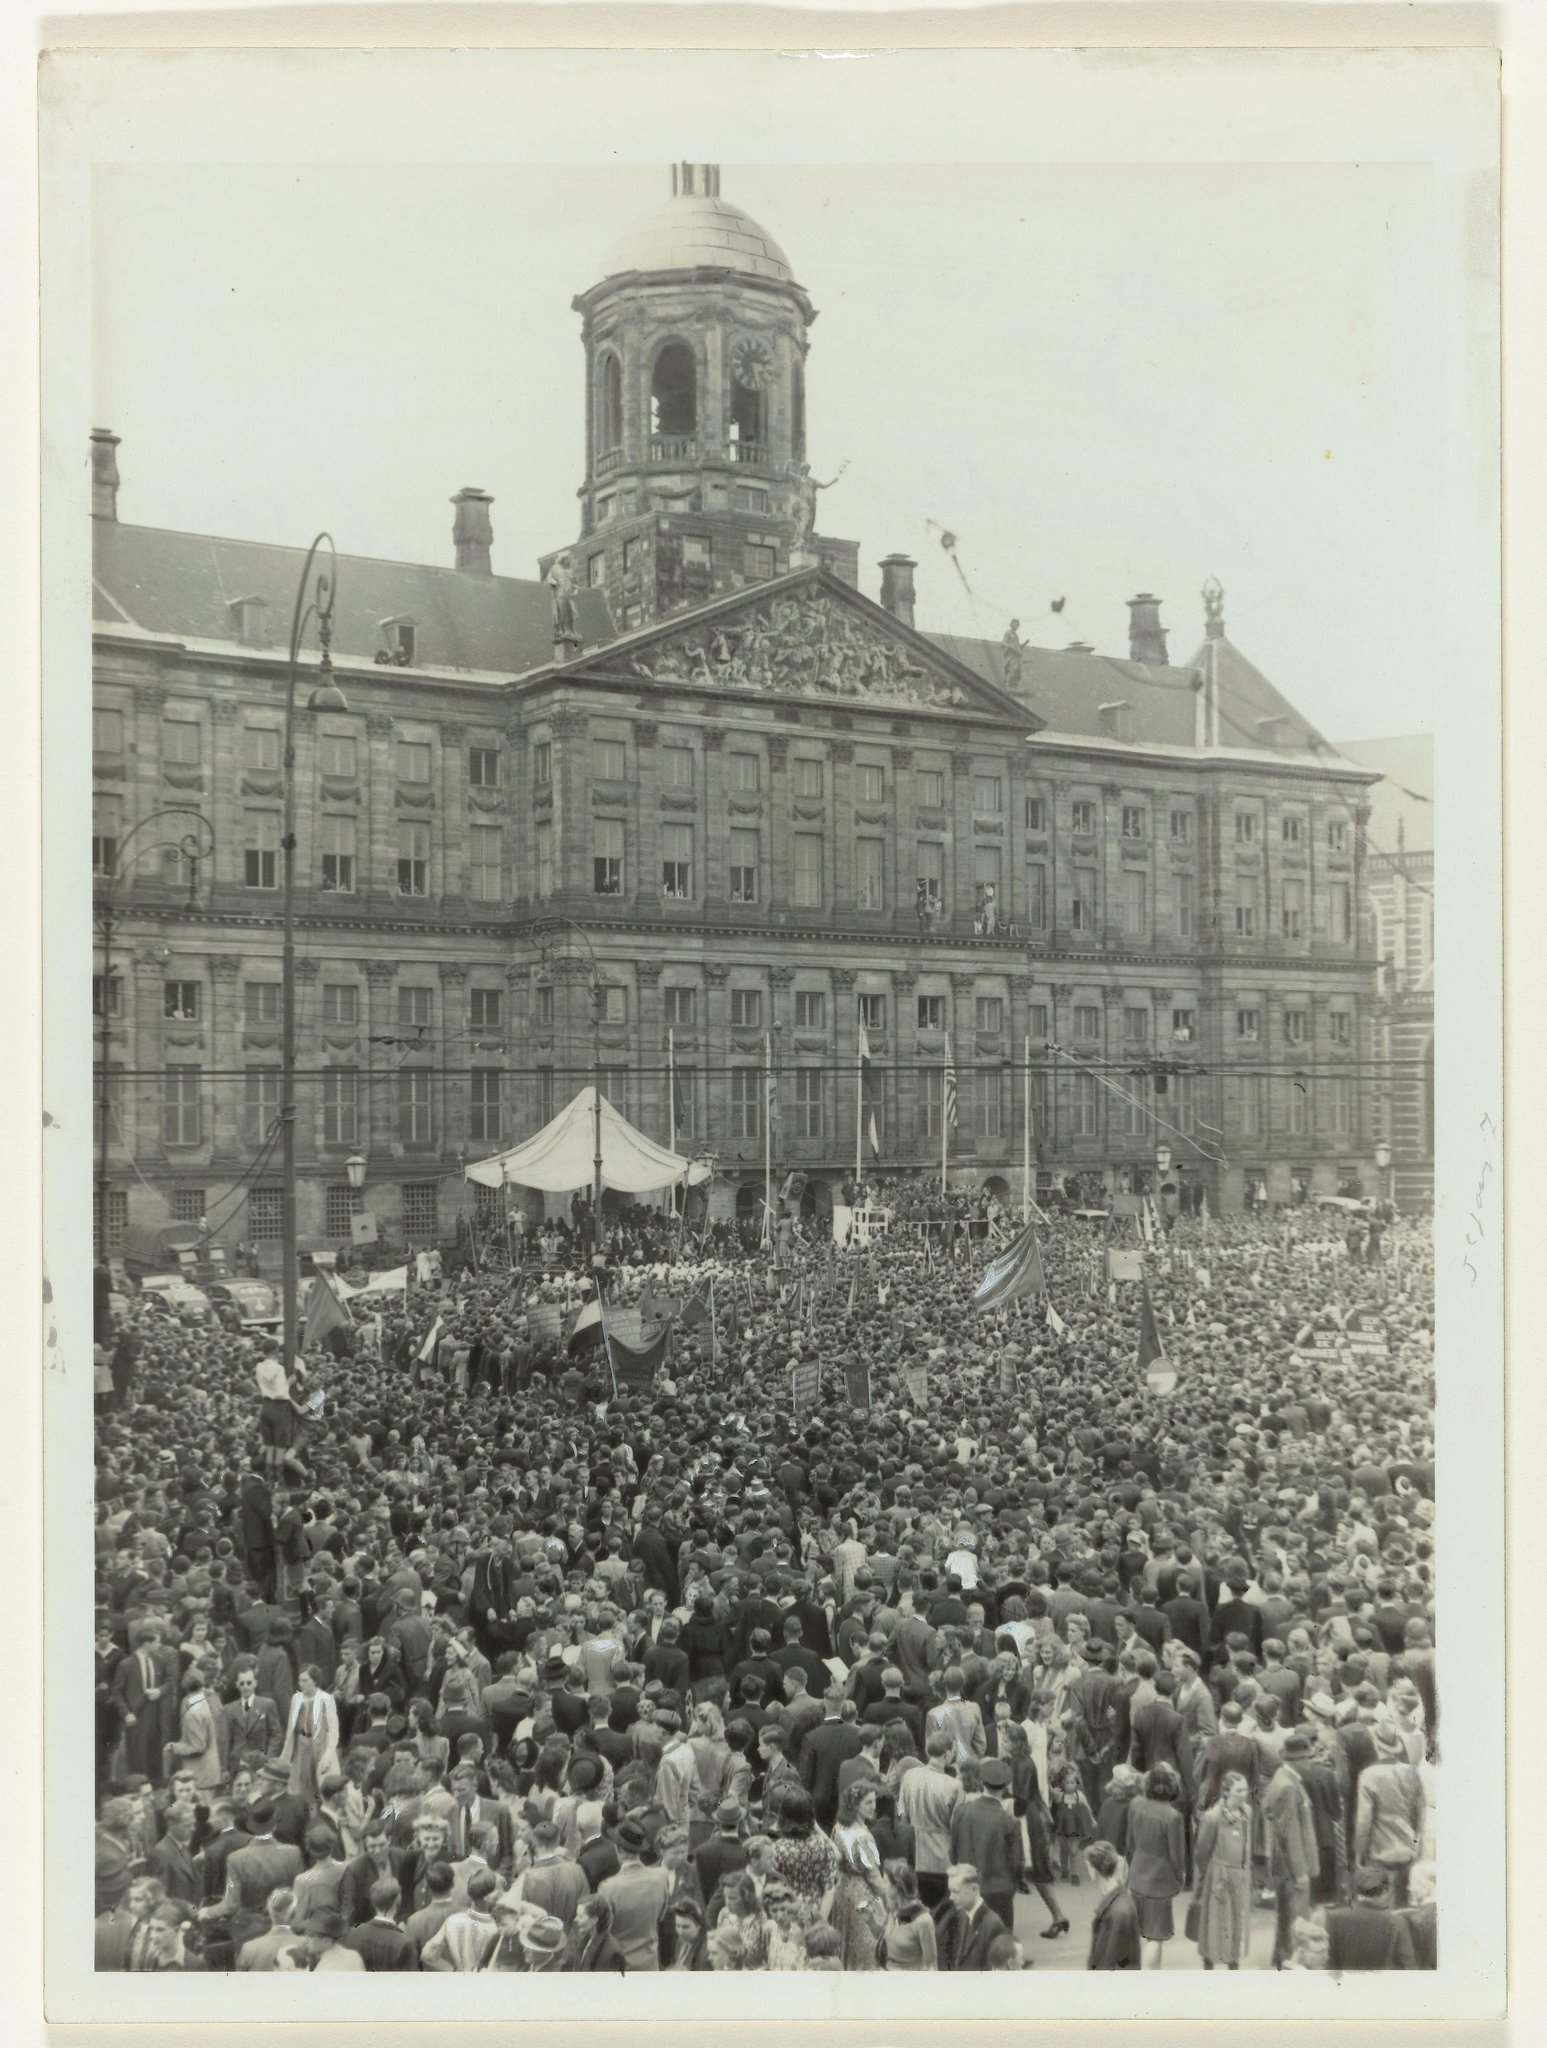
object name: documentary photograph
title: Bevrijdingsfeest op de Dam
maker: Anonymous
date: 1945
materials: photographic support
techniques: photography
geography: amsterdam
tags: dam, bevrijding van nederland (1944-1945)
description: Een grote menigte staat op de Dam voor het Koninklijk paleis. Het betreft het eerste officiele bevrijdingsfeest, met name om de Canadezen te huldigen. Op een houten tribune staan o.m. Gerbrandy en Beel. Links van de tribune is een muziektent. De mensen dragen spandoeken en vlaggen.